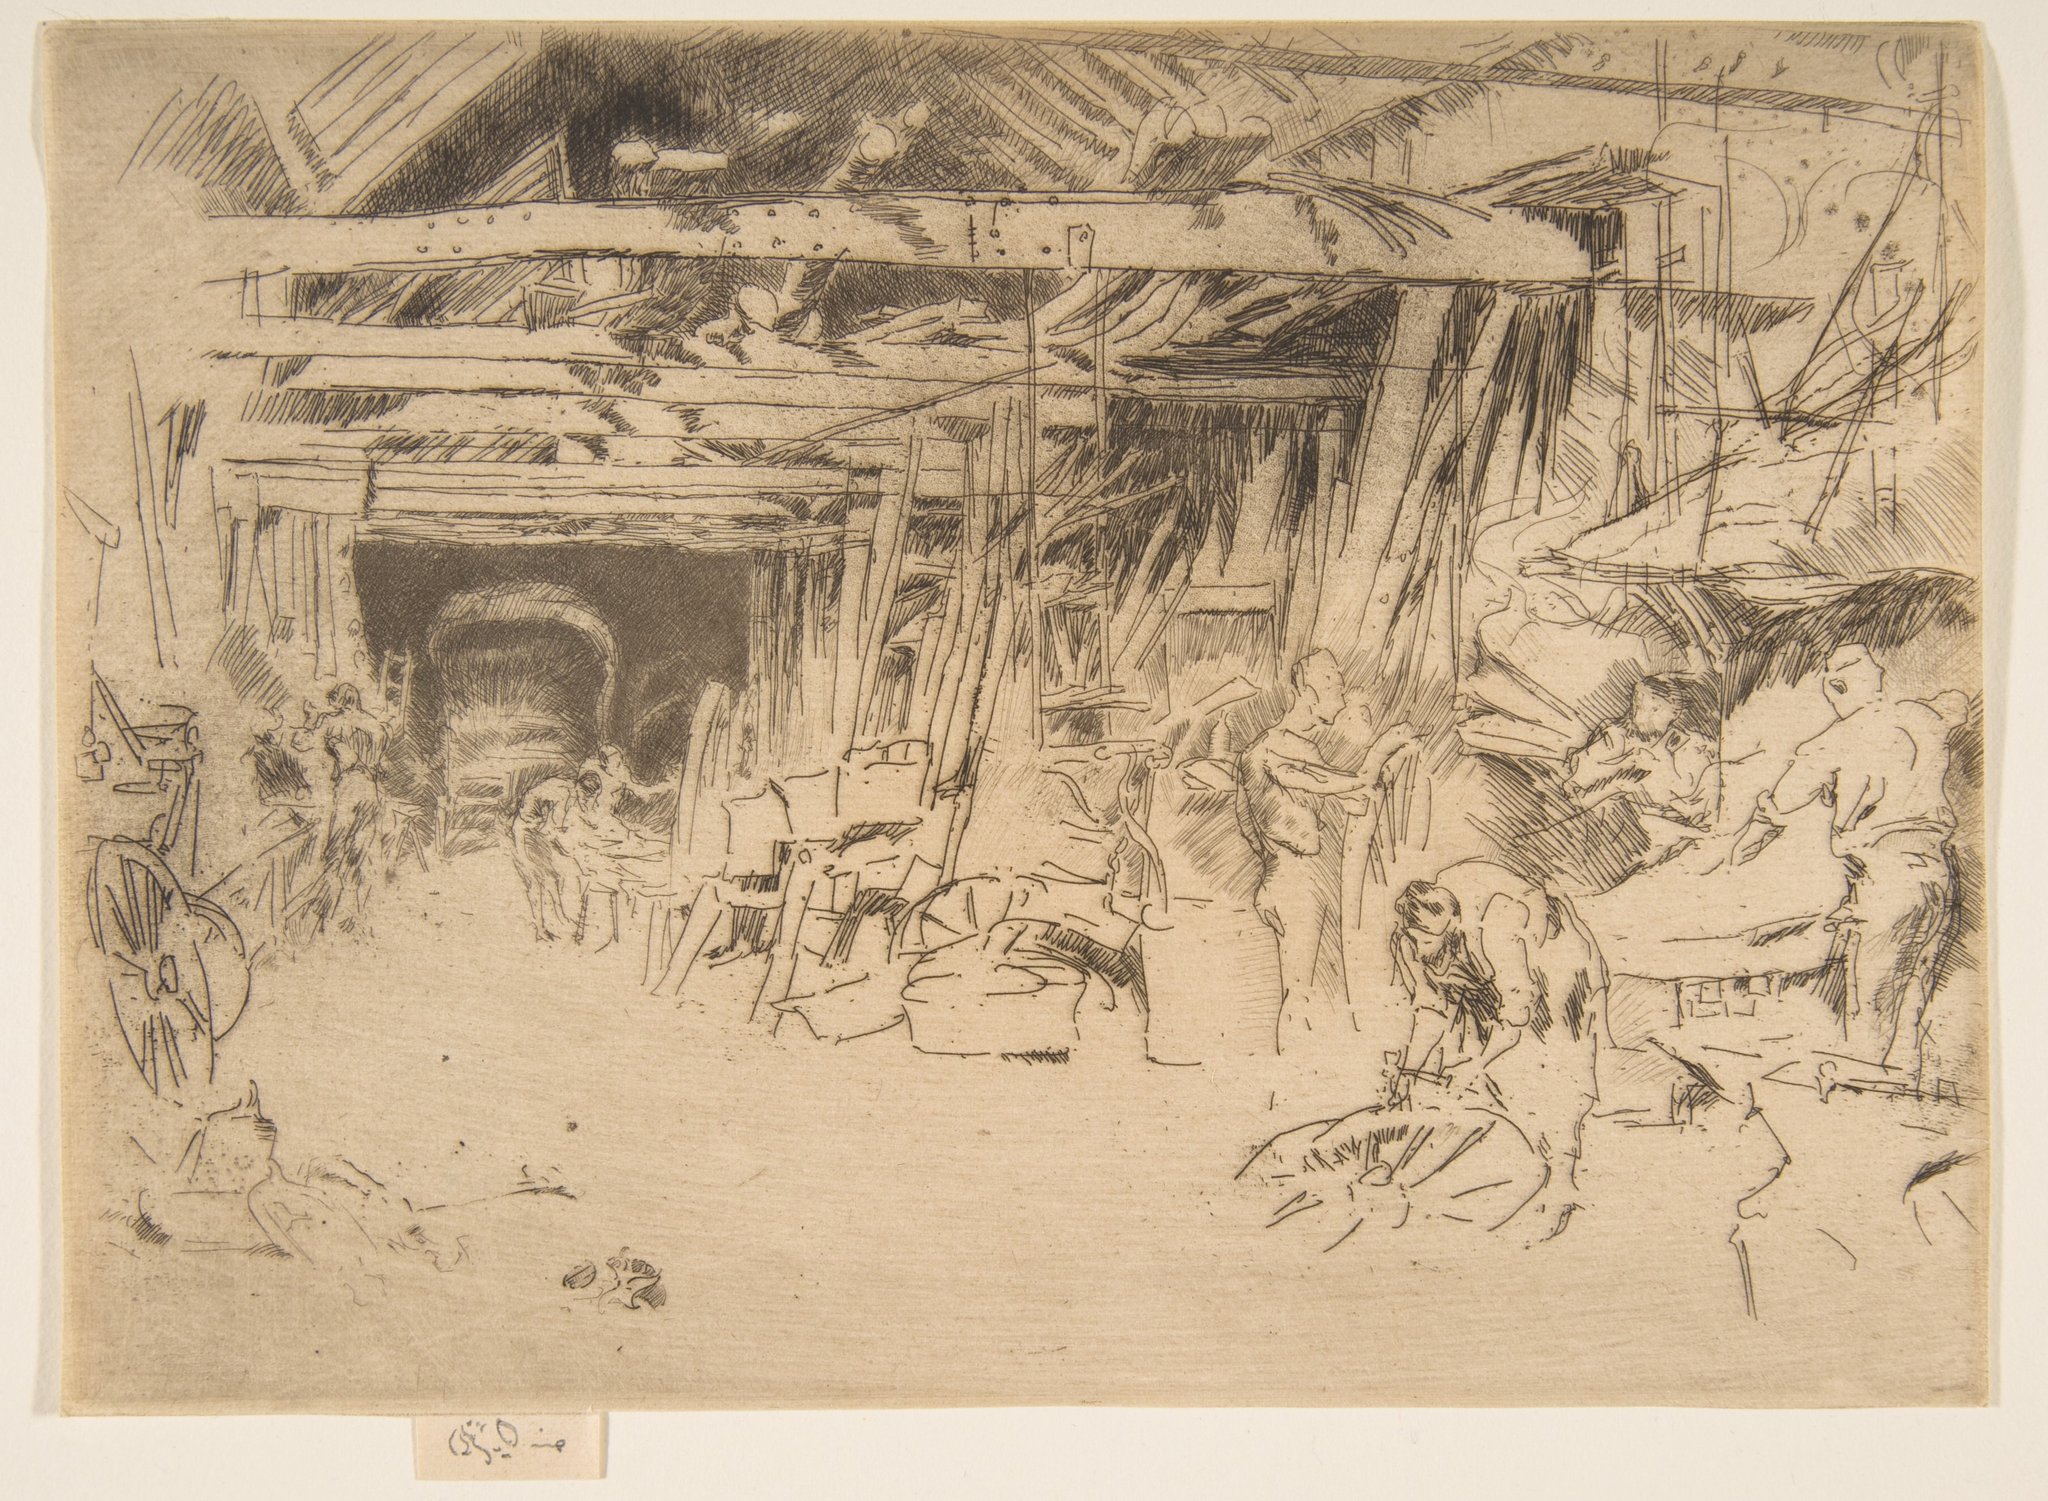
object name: print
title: Wheelwright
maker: james mcneill whistler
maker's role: artist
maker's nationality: american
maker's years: 1834-1903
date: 1879-1880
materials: ink, ivory, paper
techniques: drypoint, etching, printing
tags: men,working